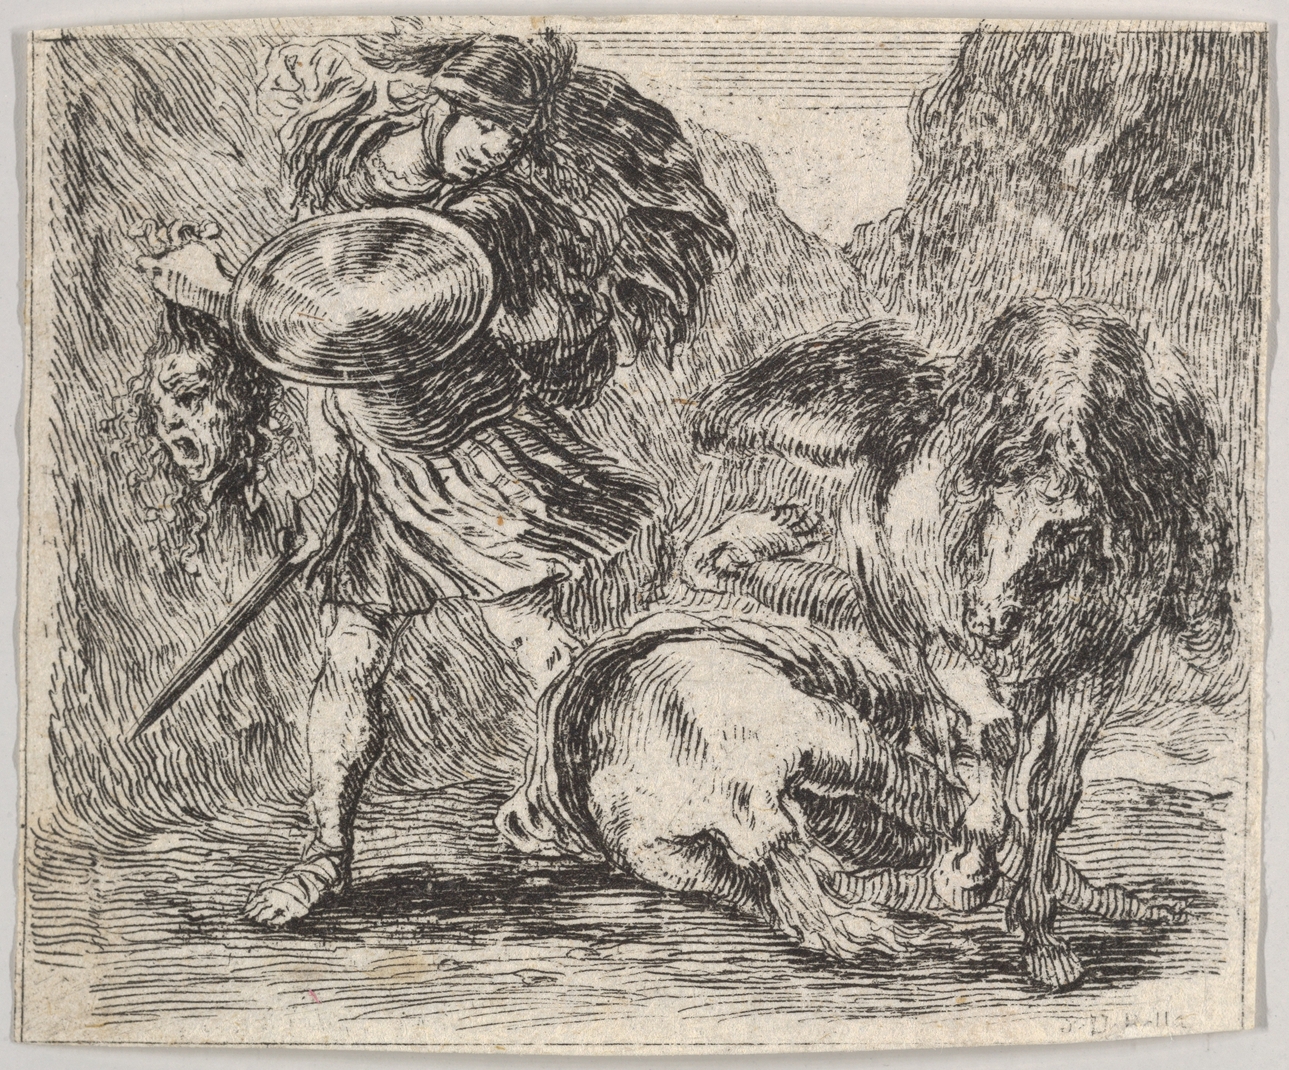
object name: print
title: Perseus and Medusa, from "Game of Mythology" (Jeu de la Mythologie)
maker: stefano della bella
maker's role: artist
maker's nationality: italian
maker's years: 1610-1664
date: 1644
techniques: etching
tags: medusa,perseus,horses